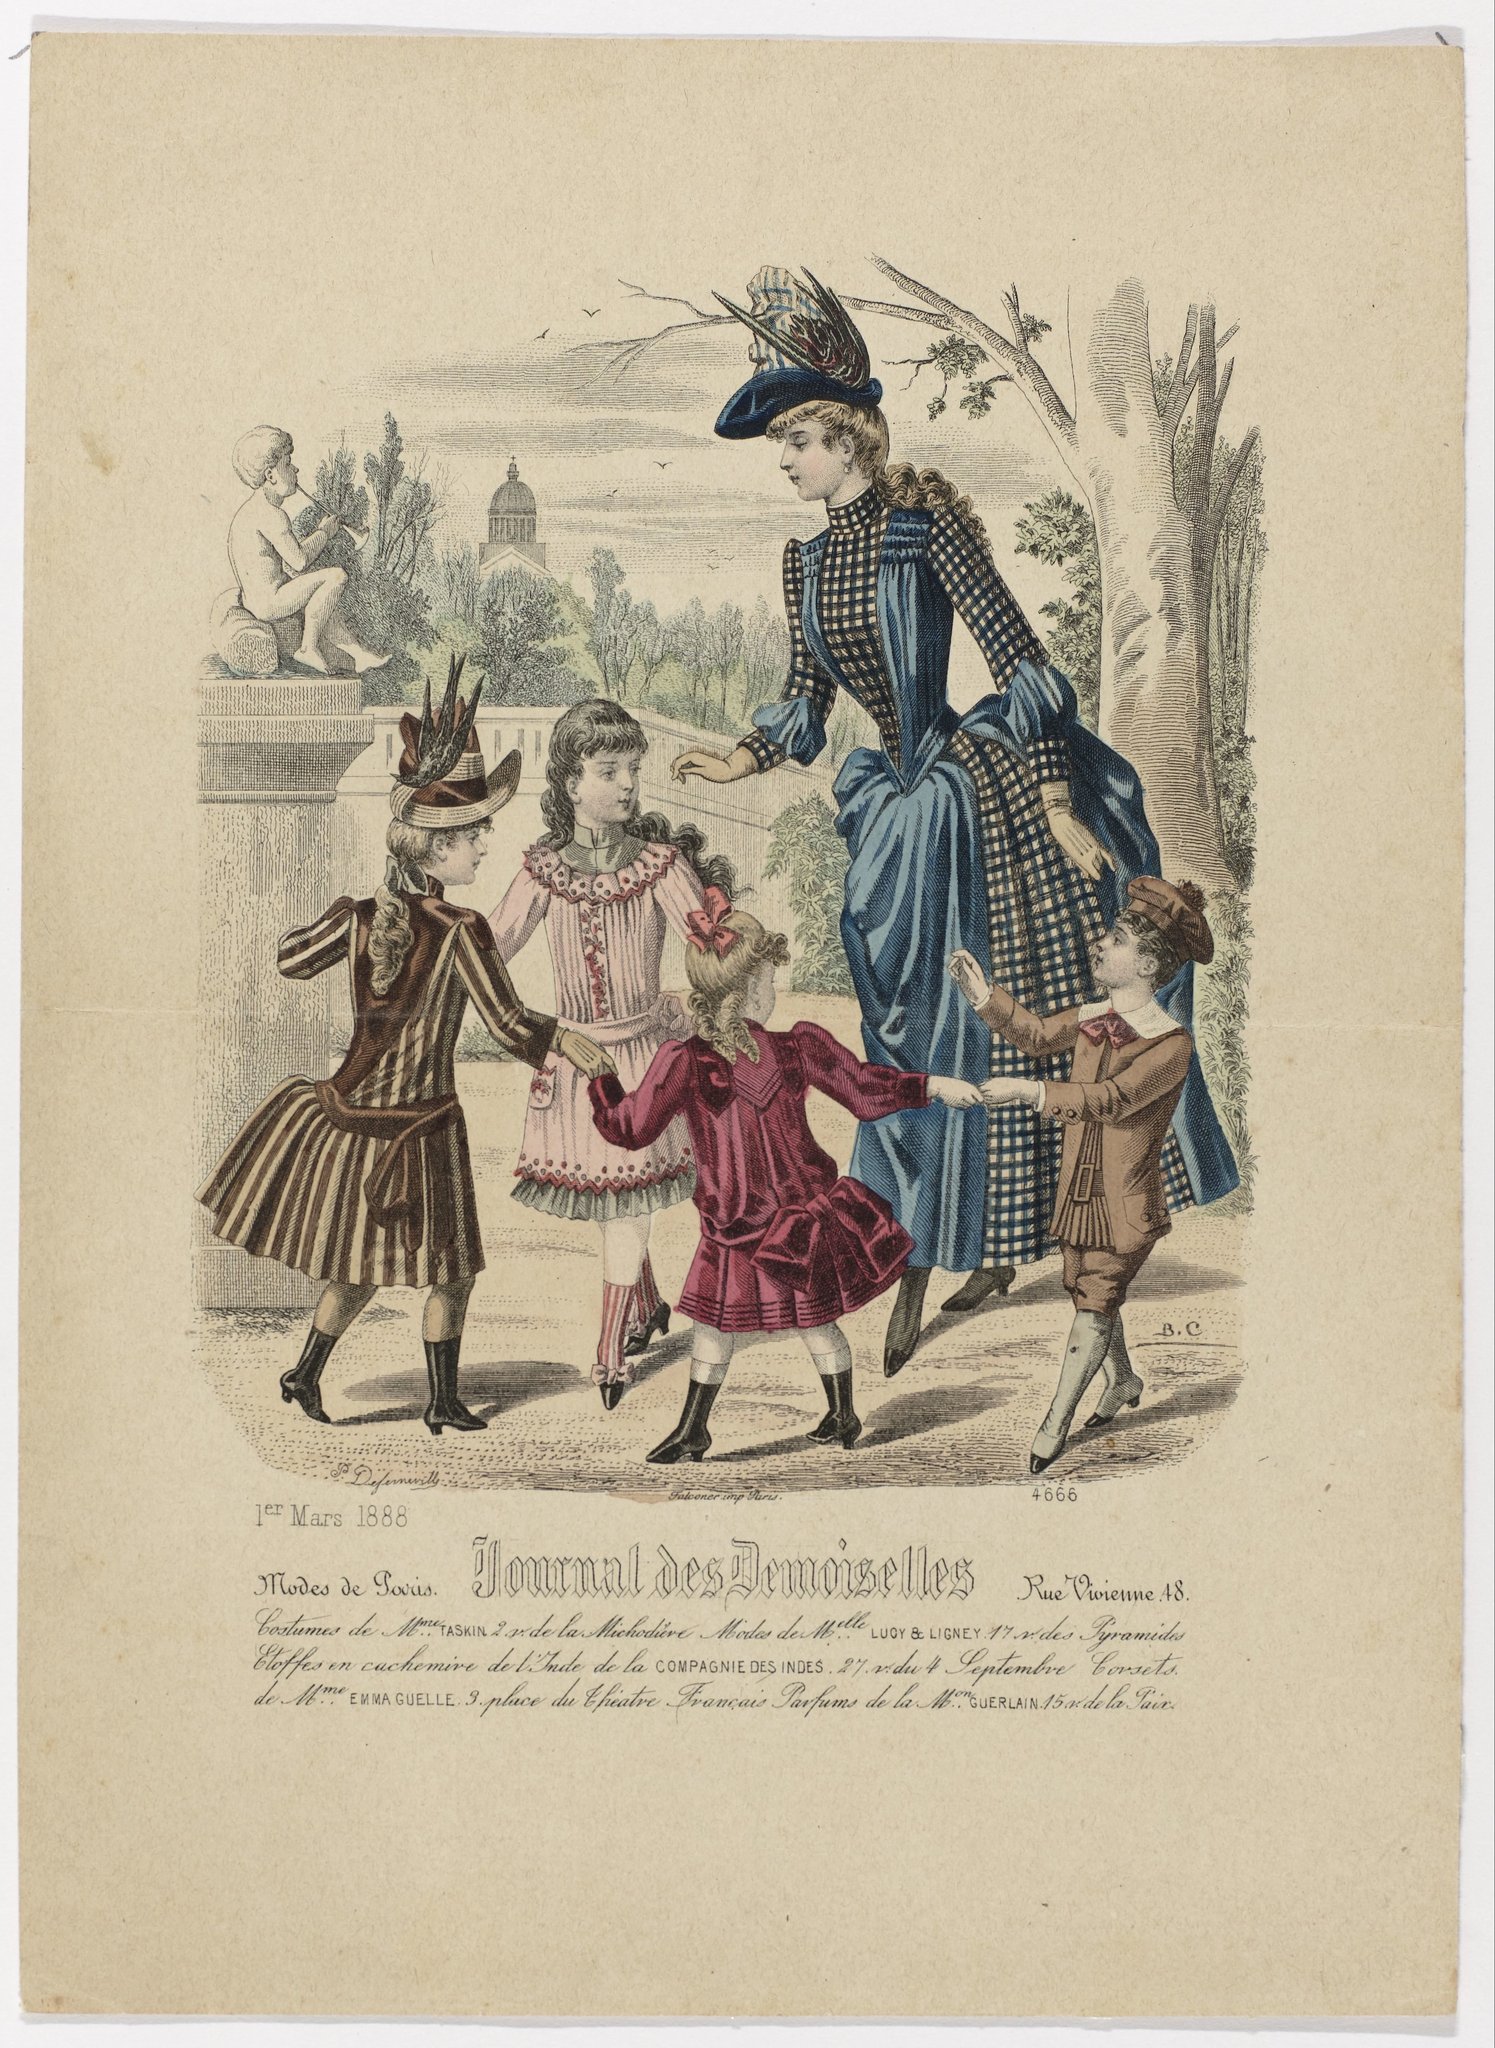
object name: fashion print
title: Journal des Demoiselles, 1 mars 1888, No. 4666 : Costumes de Mme Taskin (...)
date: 1888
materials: paper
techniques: engraving, hand coloring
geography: paris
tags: trousers, breeches (+ boys' clothes), stockings, socks (+ girls' clothes), clothing for the upper part of the body (+ boys' clothes), head-gear: beret (+ boys' clothes), ring and square dancing (children's games), fashion plates, head-gear: hat (+ women's clothes), dress, gown (+ women's clothes), statues, sculptures in garden, dress, gown (+ girls' clothes)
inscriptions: caption: ‘Costumes de Mme TASKIN 2, r, de la Michodiére Modes de Melle LUCY & LIGNEY 17 r. des Pyramides Etoffes en cachemire de l'Inde de la COMPAGNIE DES INDES, 27,r du 4 Septembre. Corsets de Mme EMMA GUELLE 3 place du Théatre Français Parfums de la M.on GUERLAIN 15 r de la Paix.’, address: ‘Rue Vivienne, 48.’, title: ‘Modes de Paris. / Journal des Demoiselles’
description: Een vrouw en vier kinderen in een tuin; de kinderen dansen in een kring. Volgens het onderschrift zijn de kostuums van Taskin. Onder de afbeelding enkele regels reclametekst voor verschillende producten. Prent uit het modetijdschrift Journal des Demoiselles (1833 -1922).